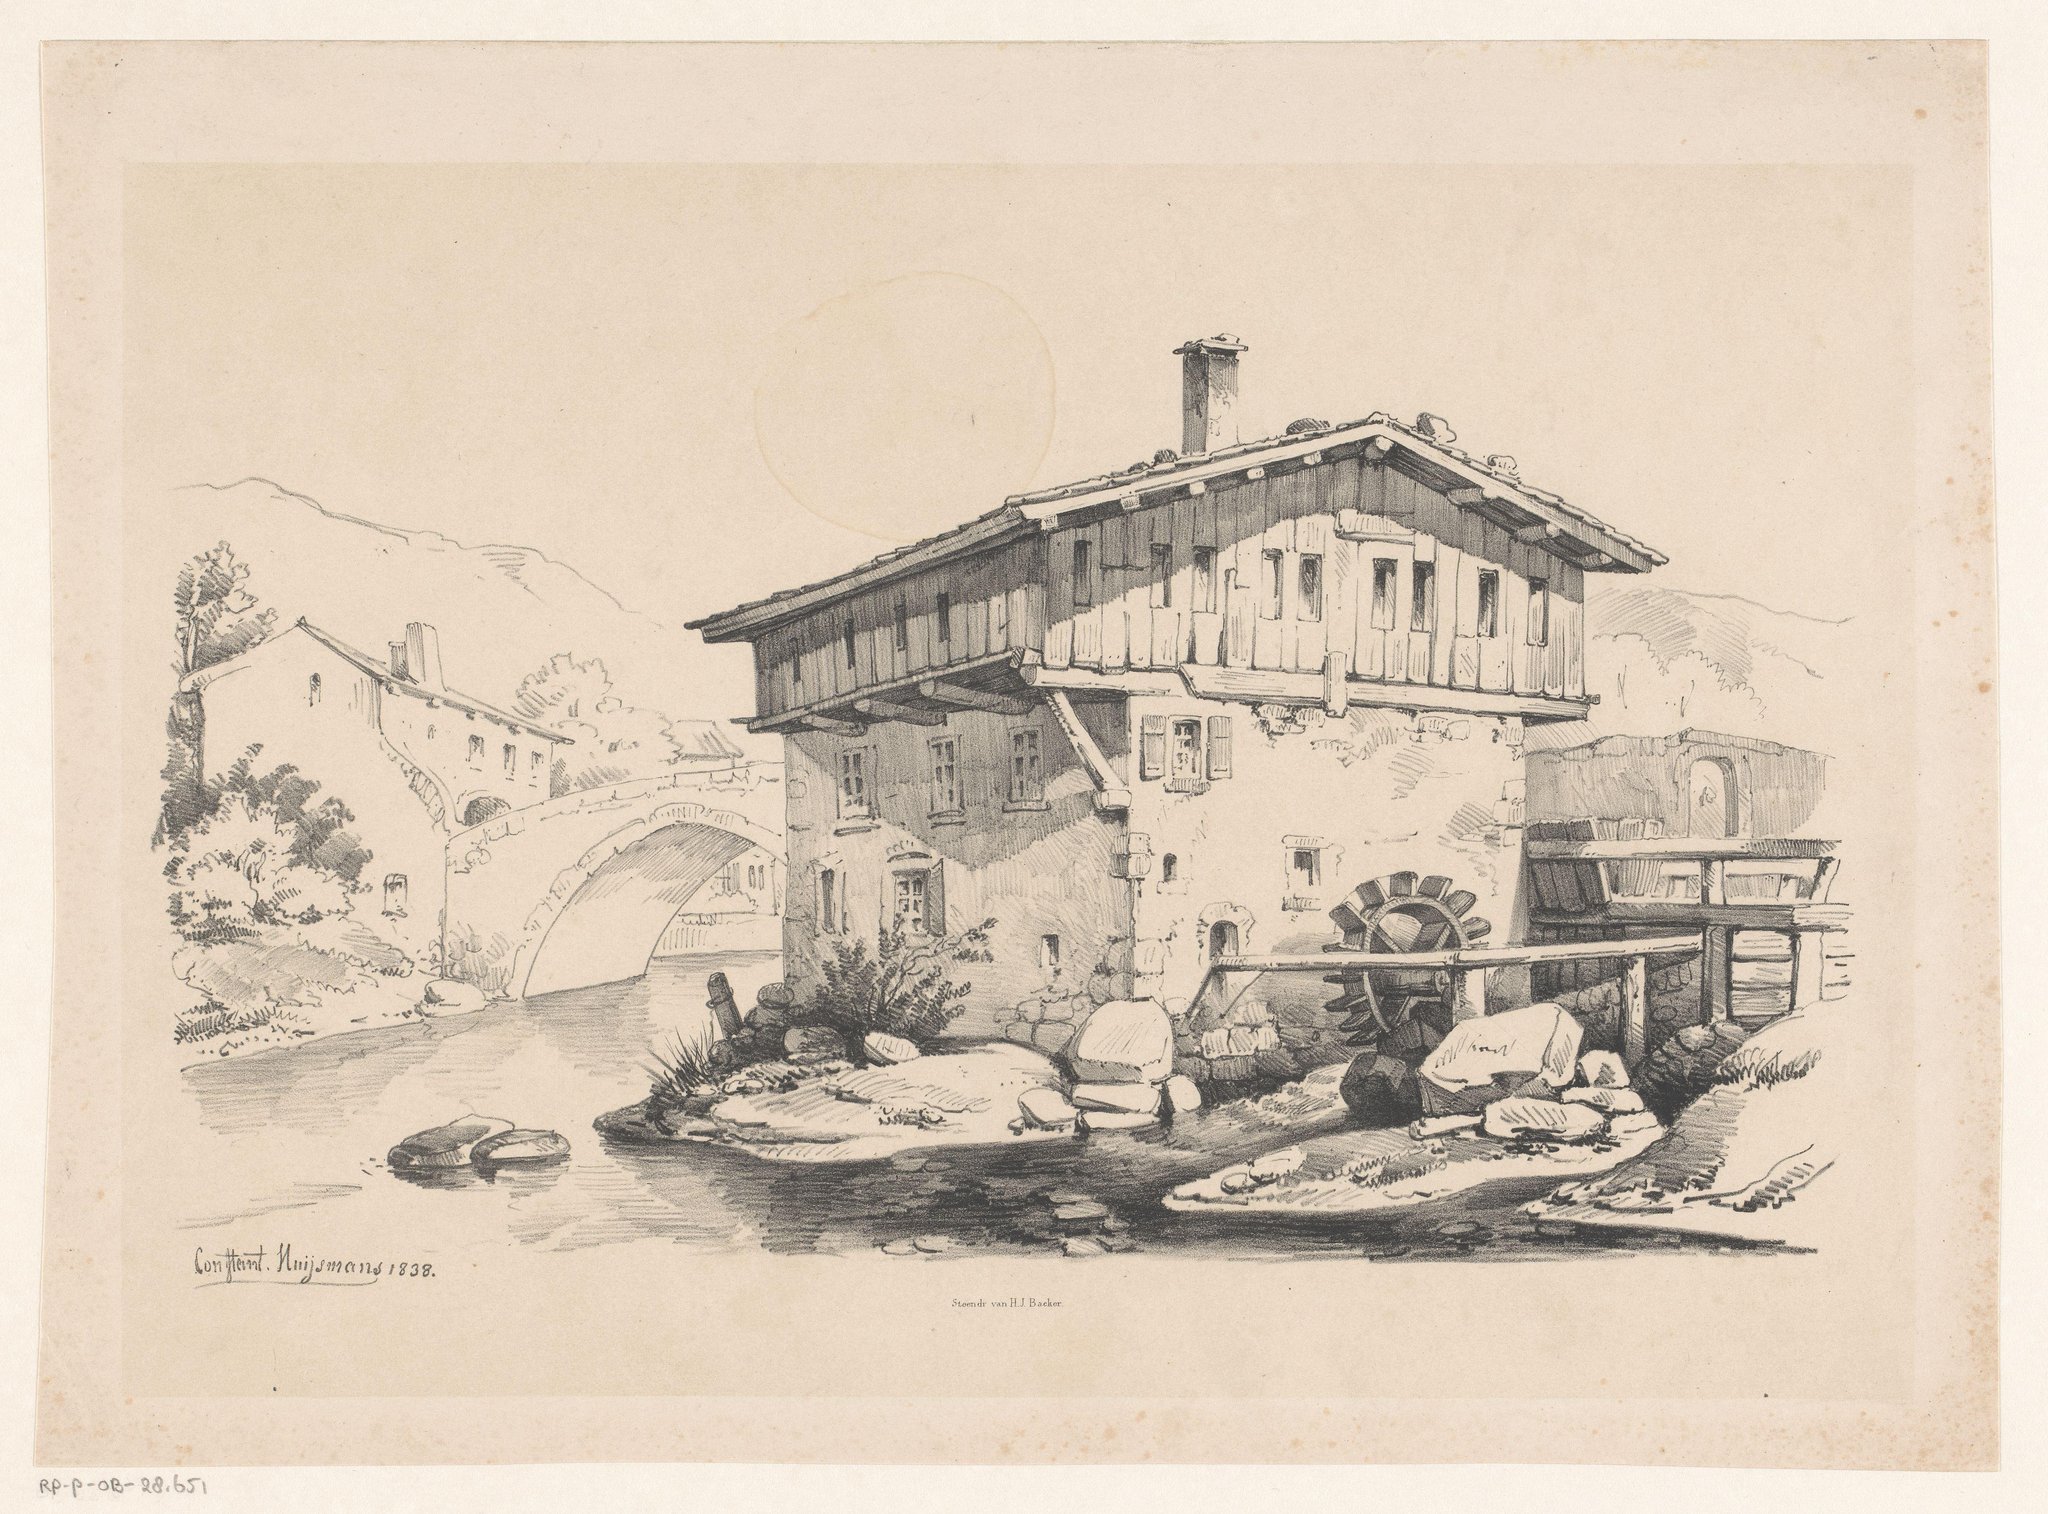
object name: print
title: Het Landschap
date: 1838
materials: paper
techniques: lithograph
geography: dordrecht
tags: watermill in landscape, bridge in village across river, canal, etc.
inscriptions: collector's mark: Lugt 2228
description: Deze prent maakt deel uit van een serie getiteld 'Het Landschap' door Constantinus Cornelis Huysmans. Deze serie werd door hem gebruikt als lesmateriaal op de Koninklijke Militaire Academie te Breda. Hij was docent handtekenen van 1837 tot 1866. Zie: W. van Giersbergen.